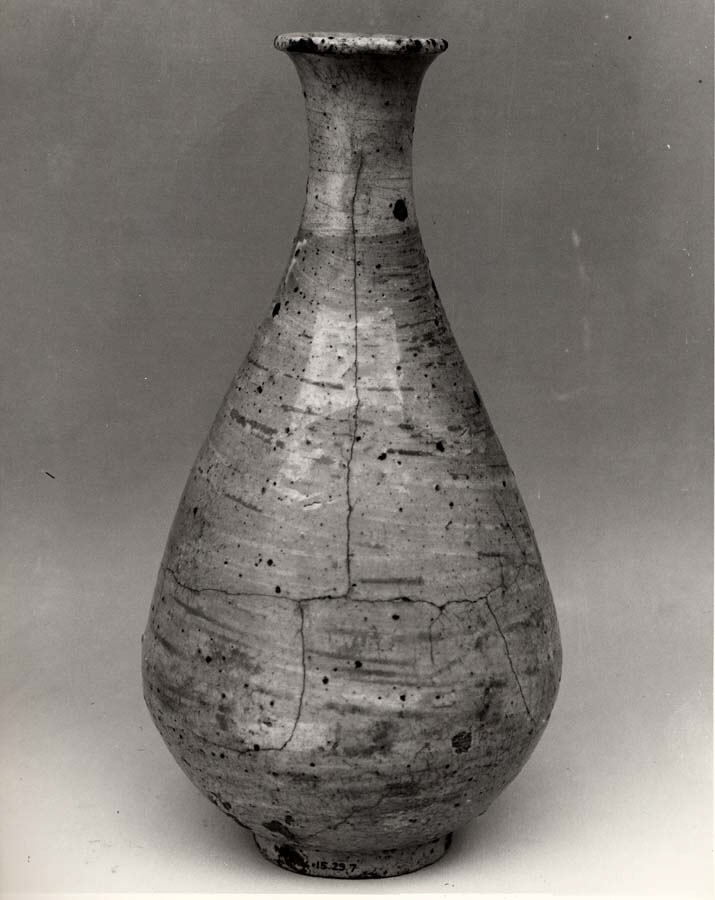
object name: vase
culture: korean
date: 1901-1933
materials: ceramic, glaze